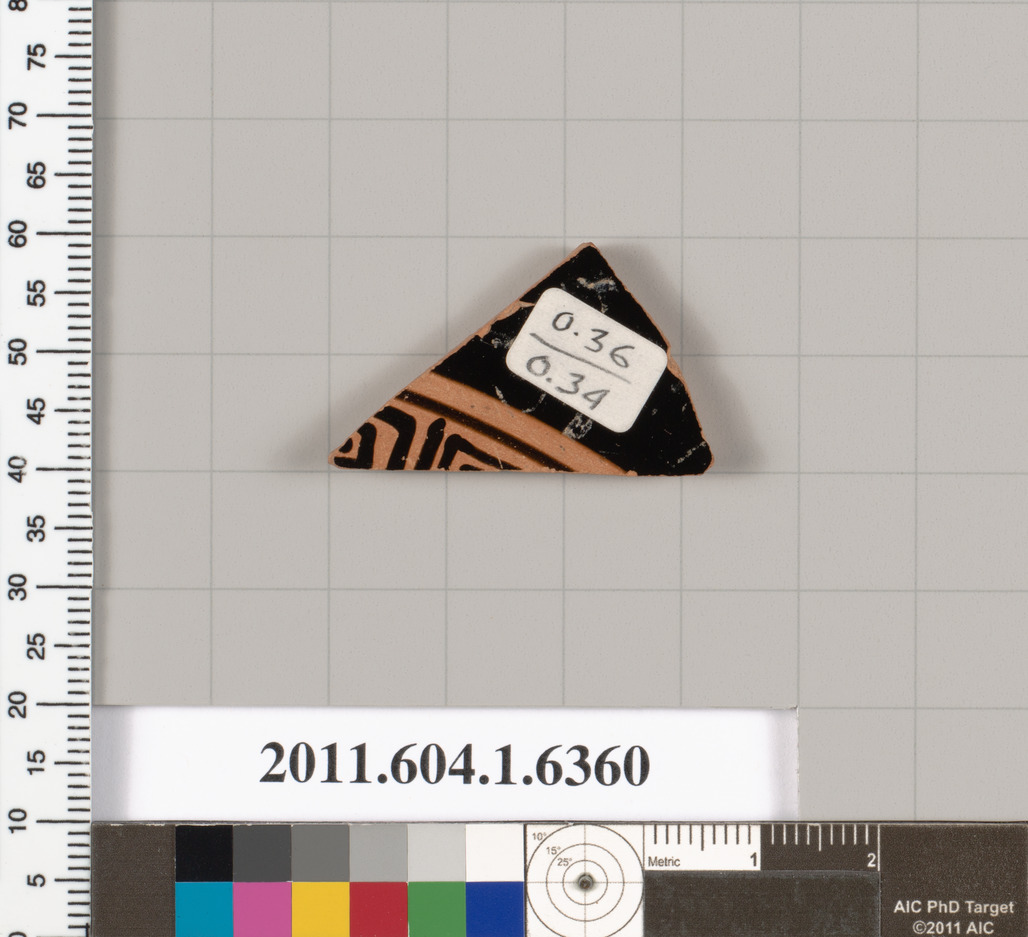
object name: kylix fragment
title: Terracotta fragment of a kylix (drinking cup)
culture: greek, attic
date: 500-480 BCE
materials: terracotta